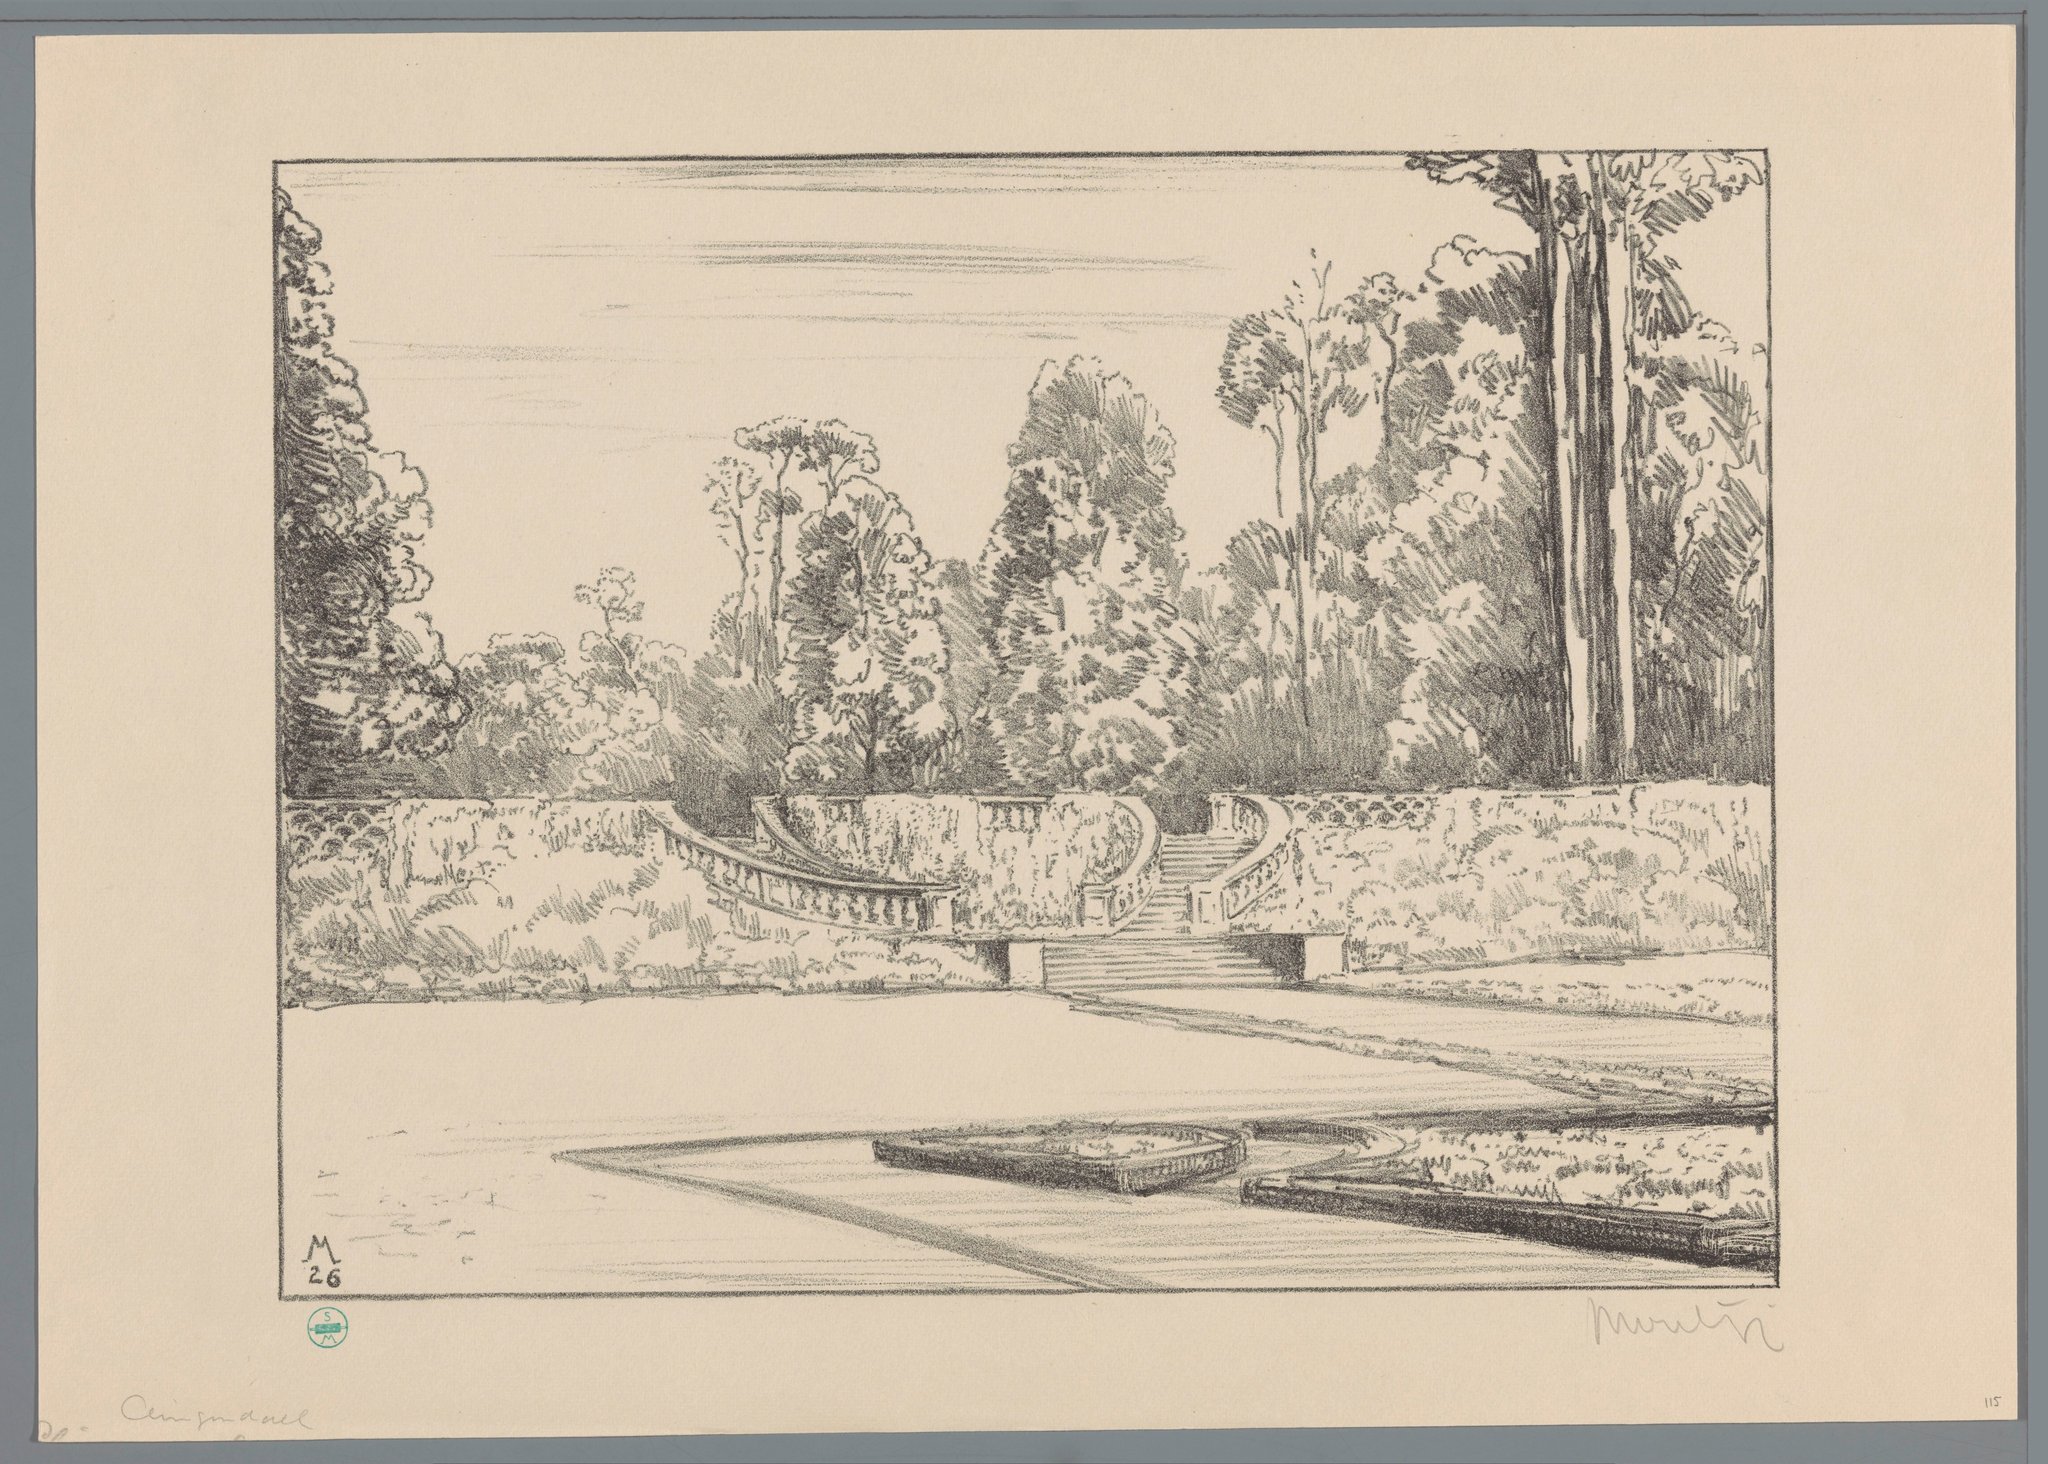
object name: print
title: Clingendaal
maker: simon moulijn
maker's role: draughtsman, print maker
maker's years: 1866-1948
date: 1926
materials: paper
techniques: lithograph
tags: french or architectonic garden; formal garden, terrace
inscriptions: collector's mark: Lugt 2228, stamp: Lugt 2362b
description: Prent gebruikt voor: Moulijn, Simon en Gelder, Hendrik Enno van. Oude buitenplaatsen rondom 's-Gravenhage. 's-Gravenhage: Gemeentebestuur, 1929.